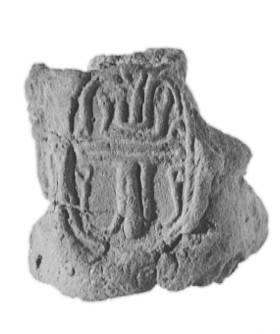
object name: sealing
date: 2030-1640 BCE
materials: clay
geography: egypt